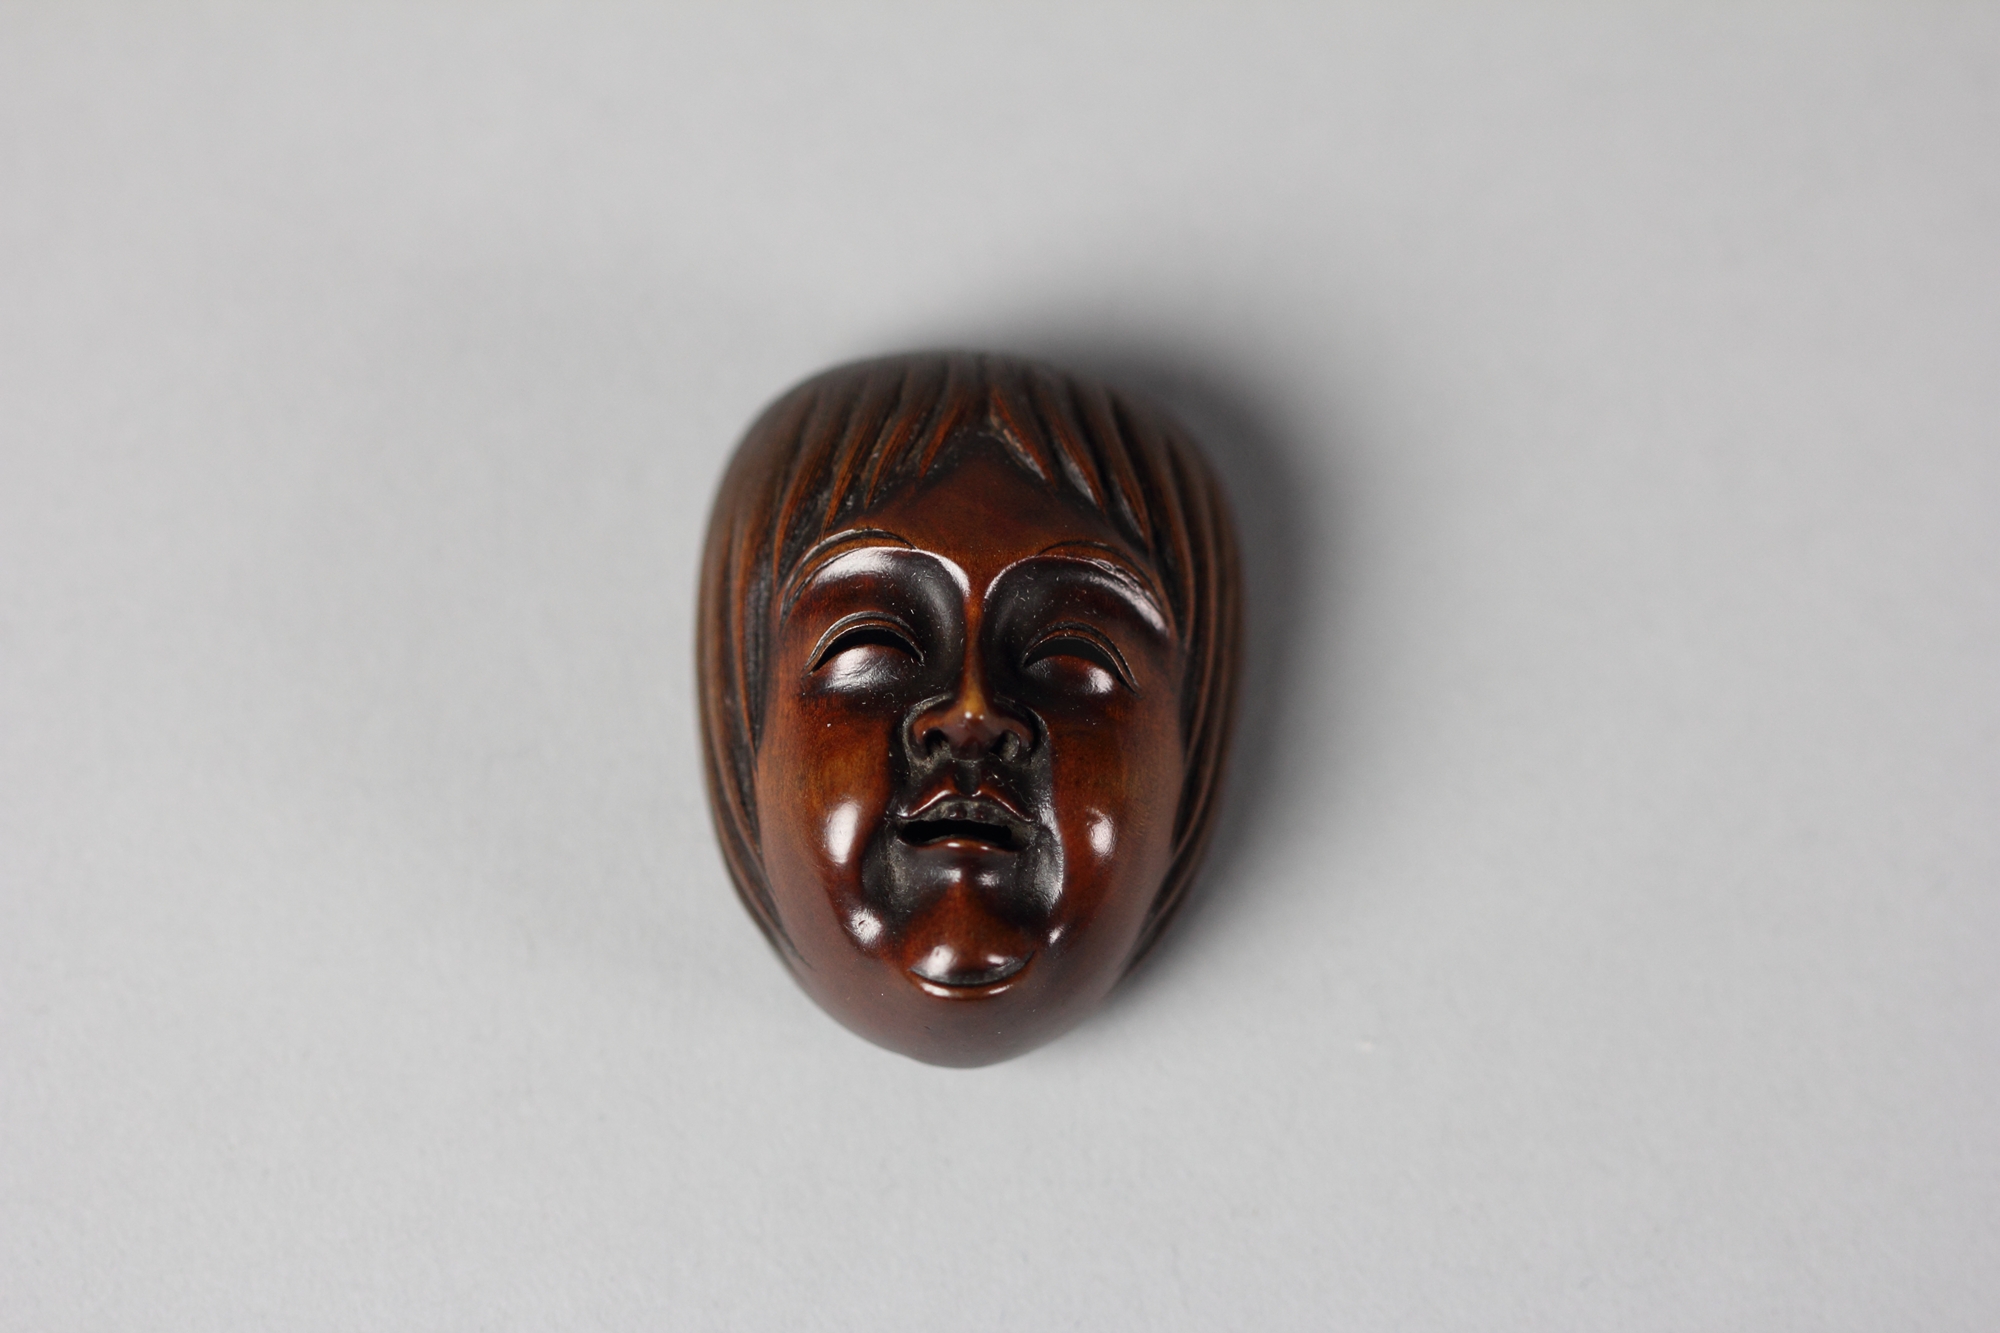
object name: netsuke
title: Netsuke of Noh Mask; Shōjō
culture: japanese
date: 1801-1900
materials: wood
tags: masks